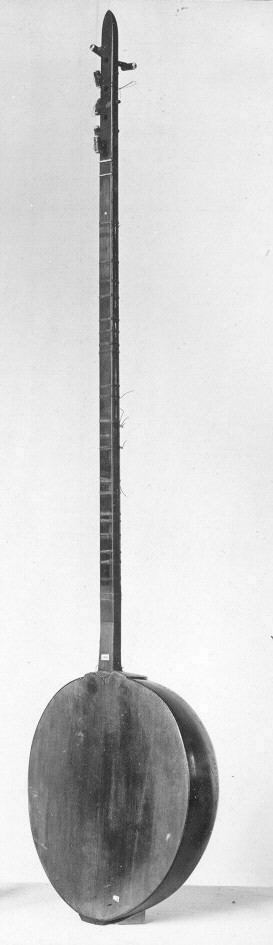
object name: tanbur kabir turki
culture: turkish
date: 1867-1900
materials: wood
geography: turkey